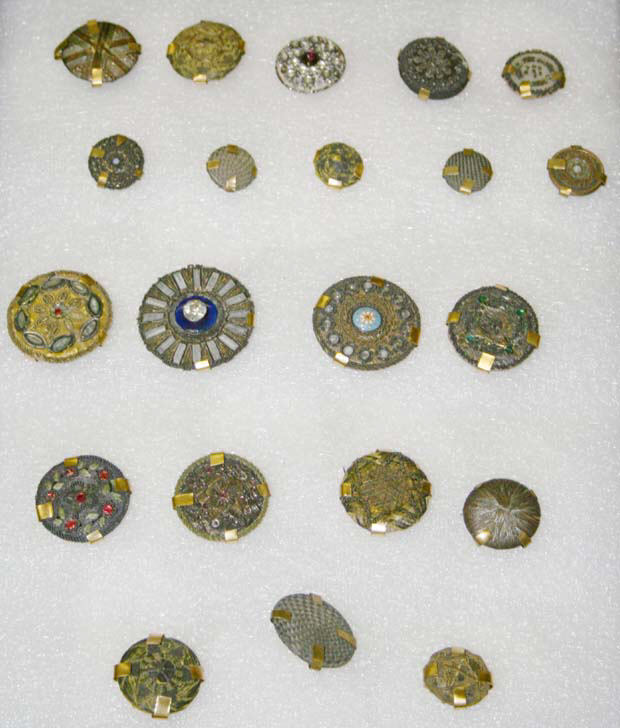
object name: button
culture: french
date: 1775